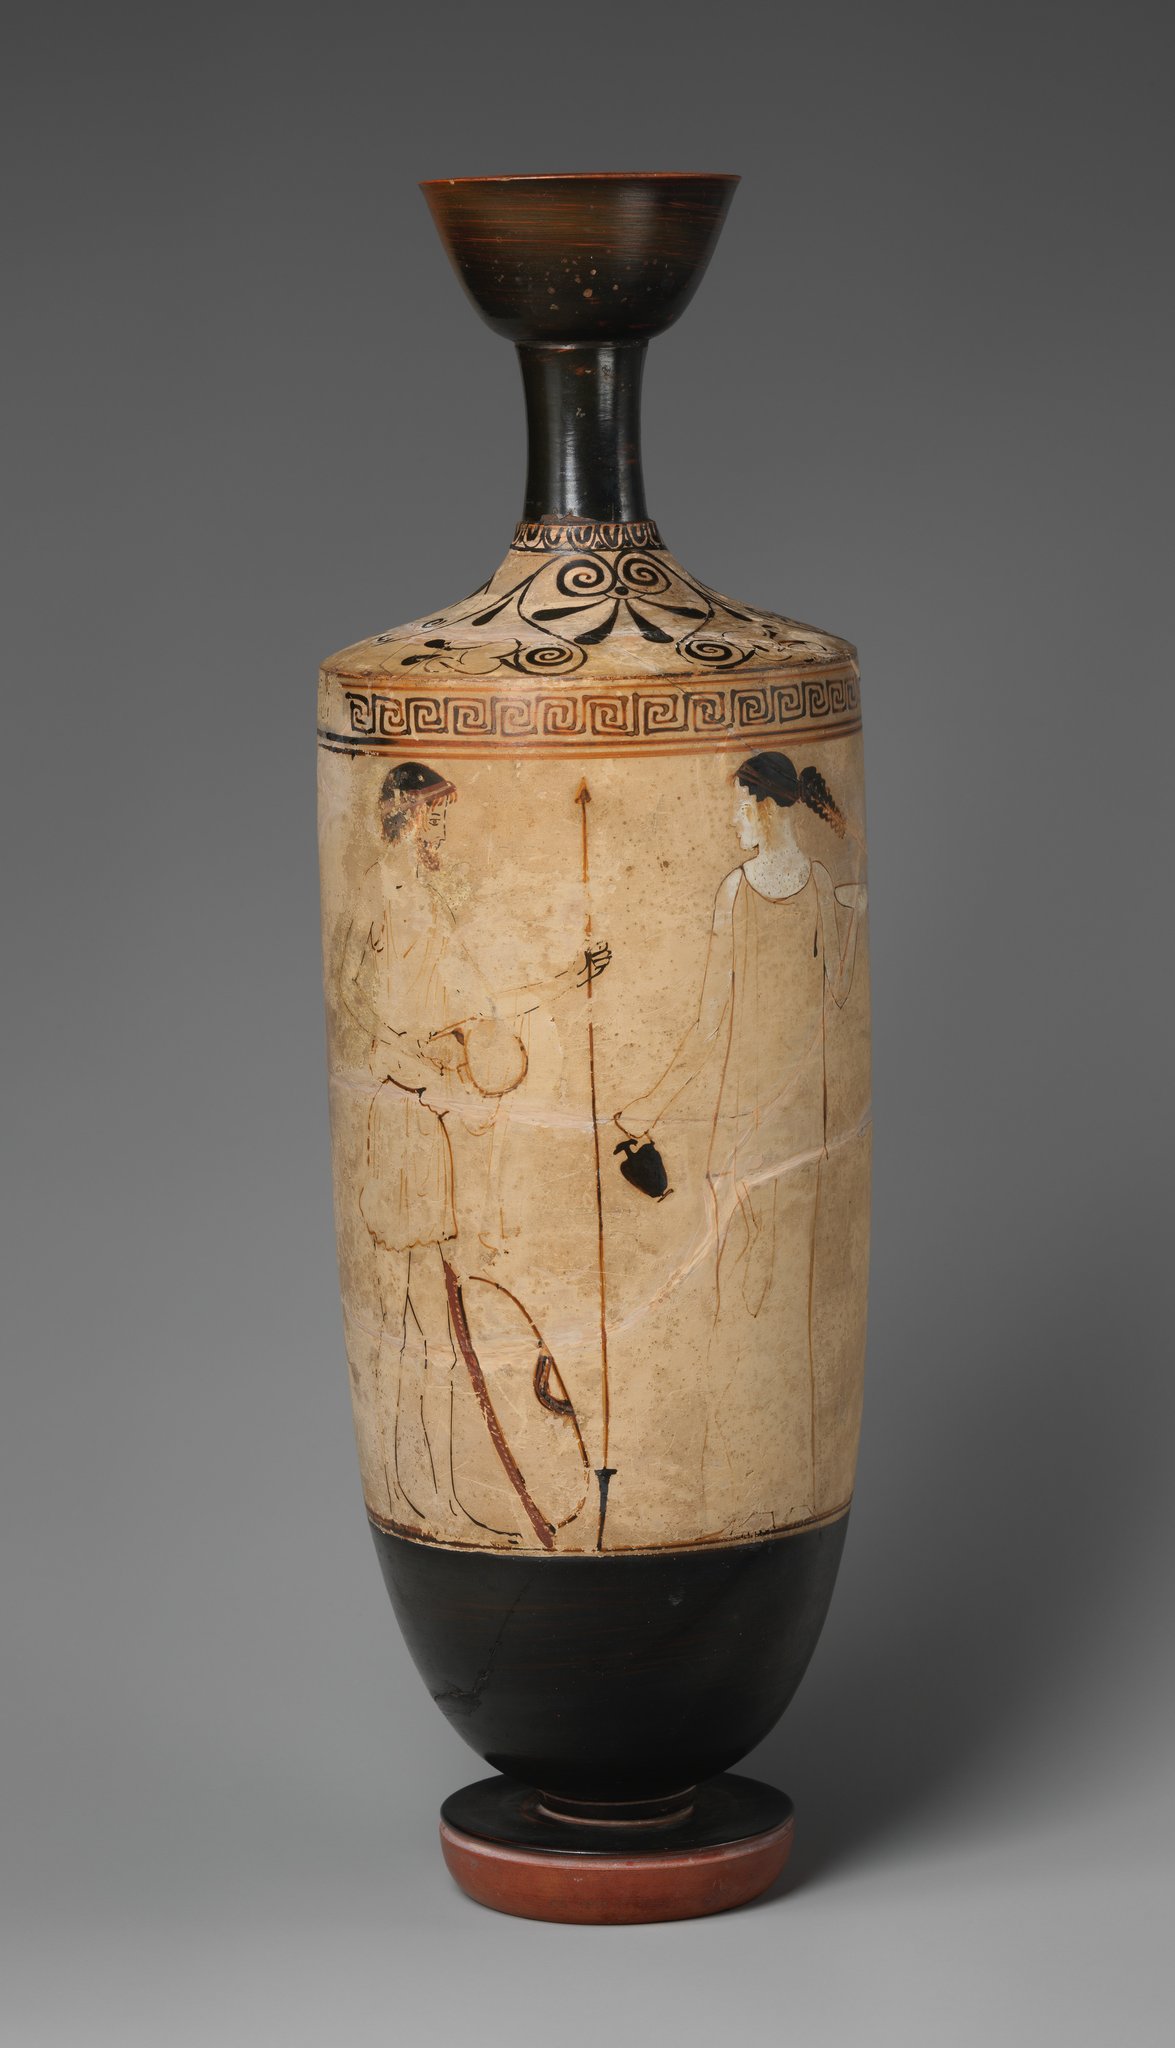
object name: lekythos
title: Terracotta lekythos (oil flask)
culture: greek, attic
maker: villa giulia painter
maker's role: artist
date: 460 BCE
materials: terracotta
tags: shields,men,women,warriors